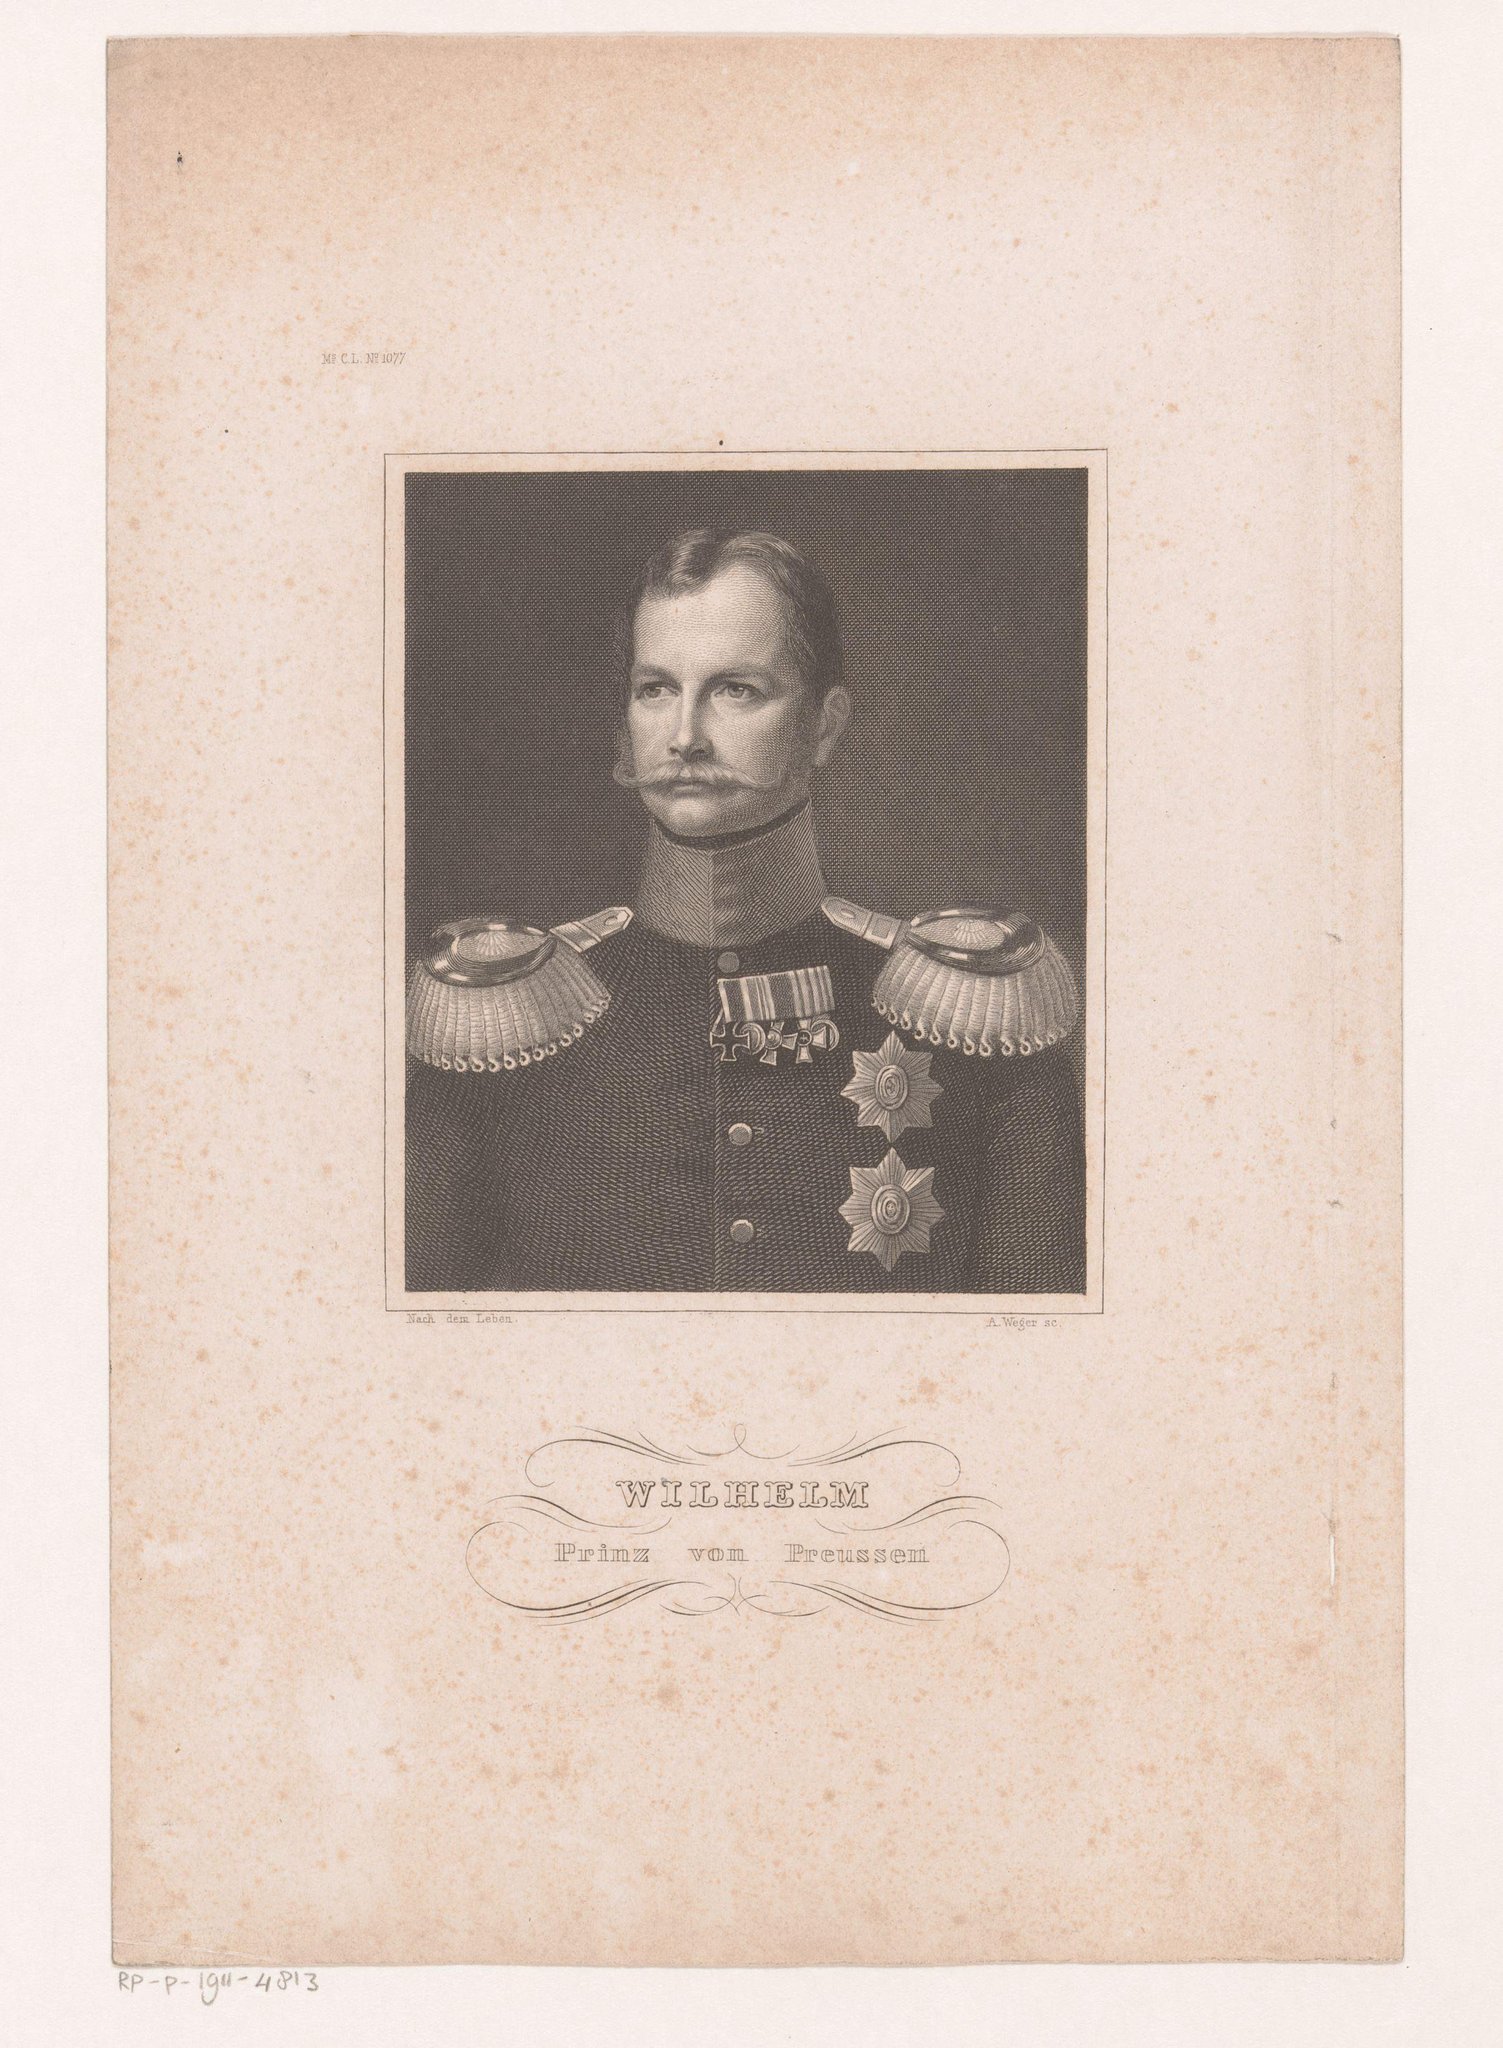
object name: print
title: Portret van Wilhelm I, keizer van Duitsland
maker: august weger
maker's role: print maker, printer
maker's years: 1823-1892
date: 1849-1855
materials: paper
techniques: engraving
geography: leipzig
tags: berlin, wilhelm i (keizer van duitsland), historical persons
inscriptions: collector's mark: Lugt 2228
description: Prent afkomstig uit: Conversations-Lexikon für die gebildeten Stände, voor het eerst uitgegeven tussen 1840-1855.